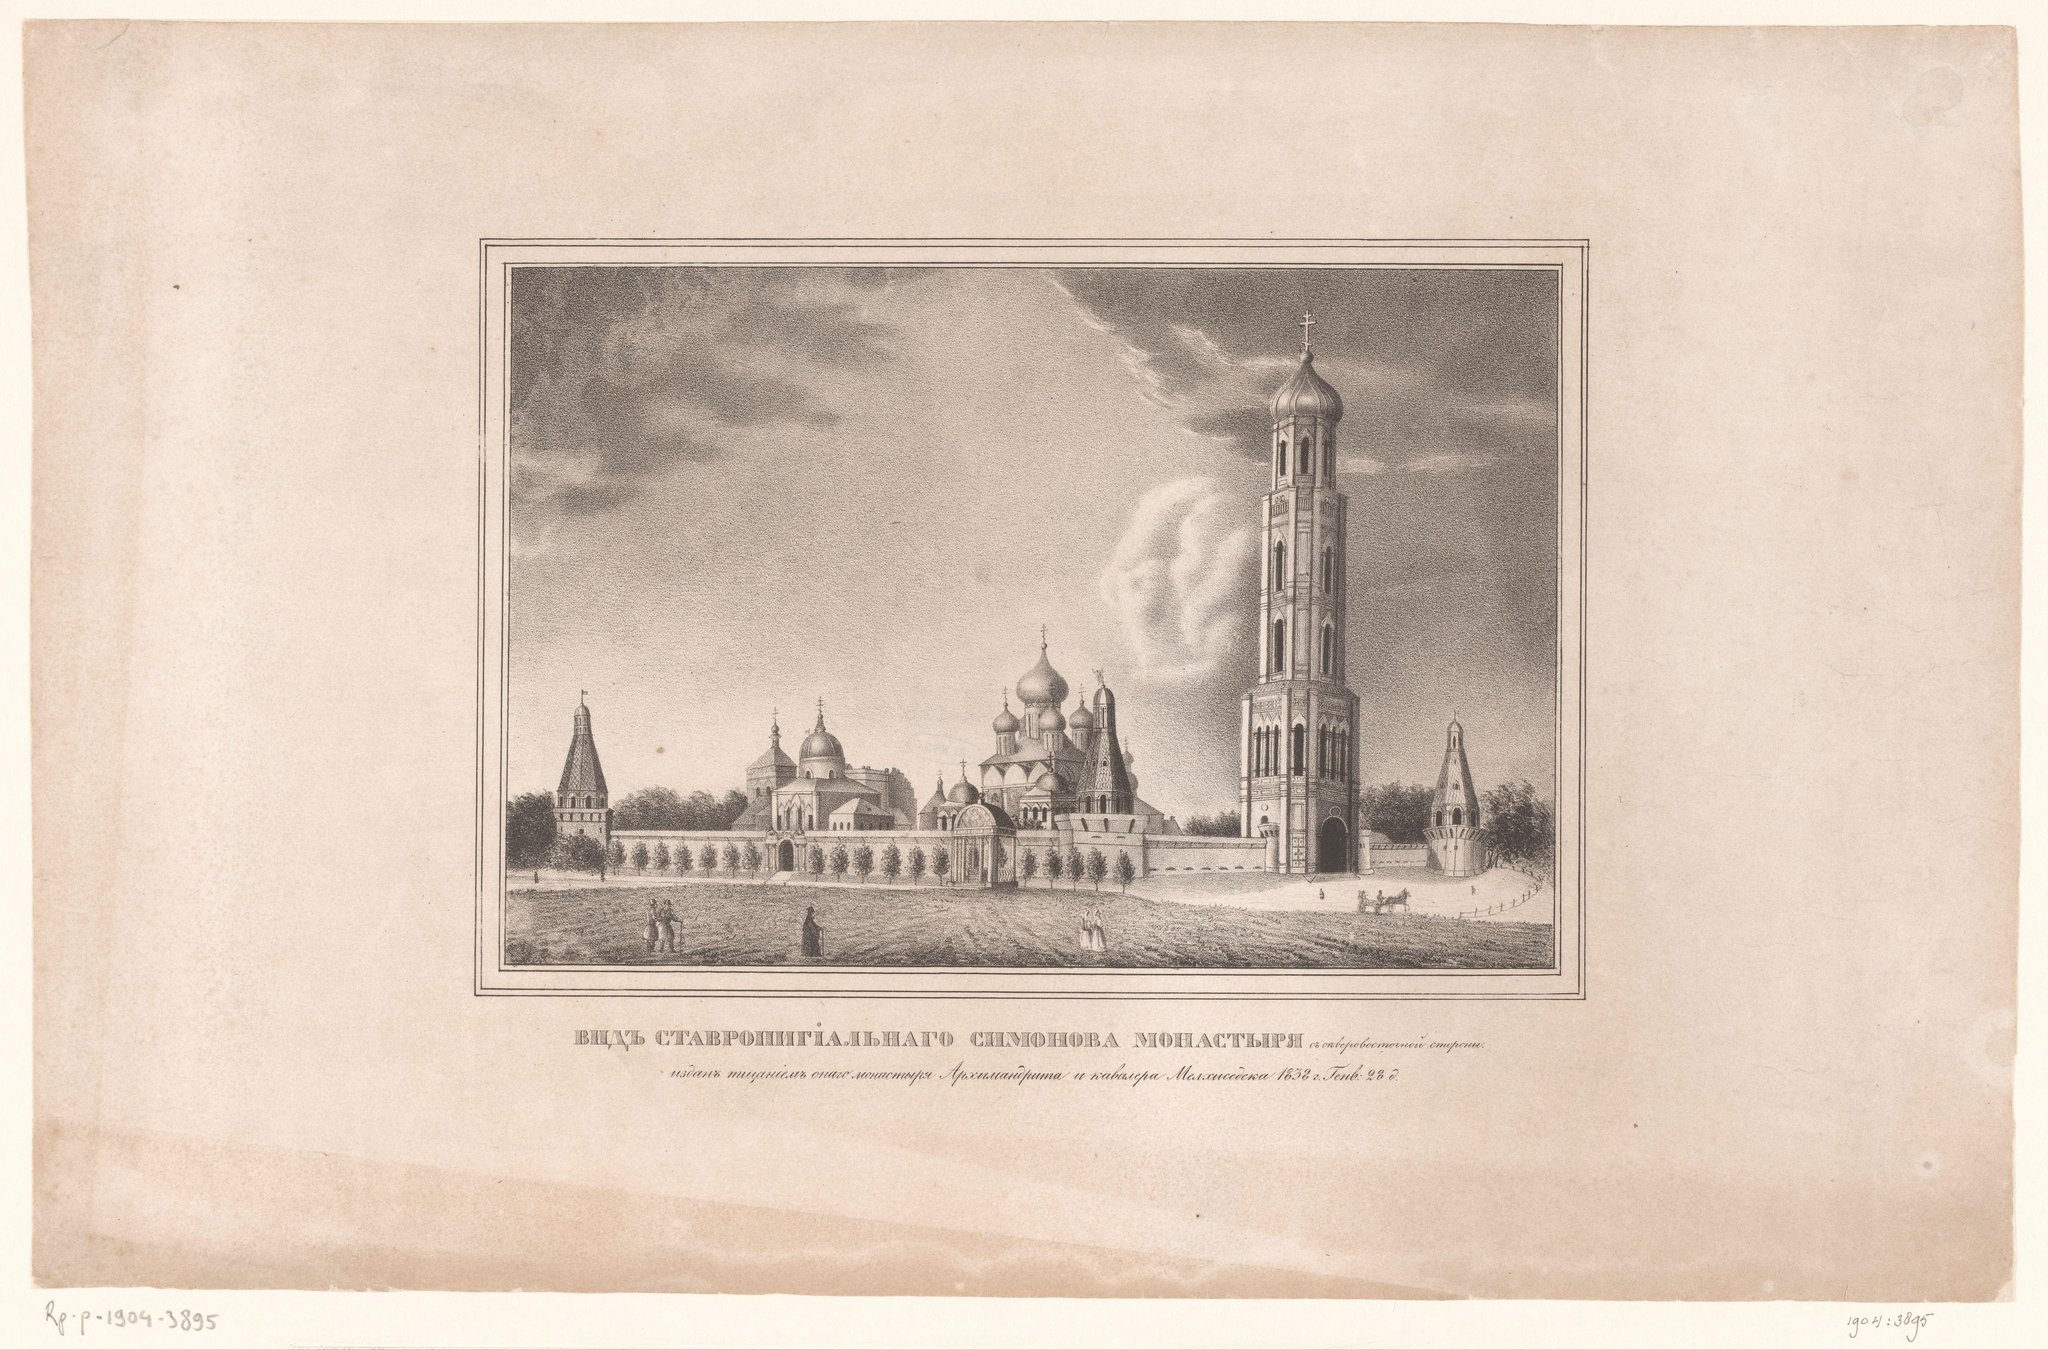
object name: print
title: Gezicht op het Simonovklooster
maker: Anonymous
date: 1832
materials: paper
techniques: lithograph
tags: cloisters ~ monastery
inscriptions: collector's mark: Lugt 2228